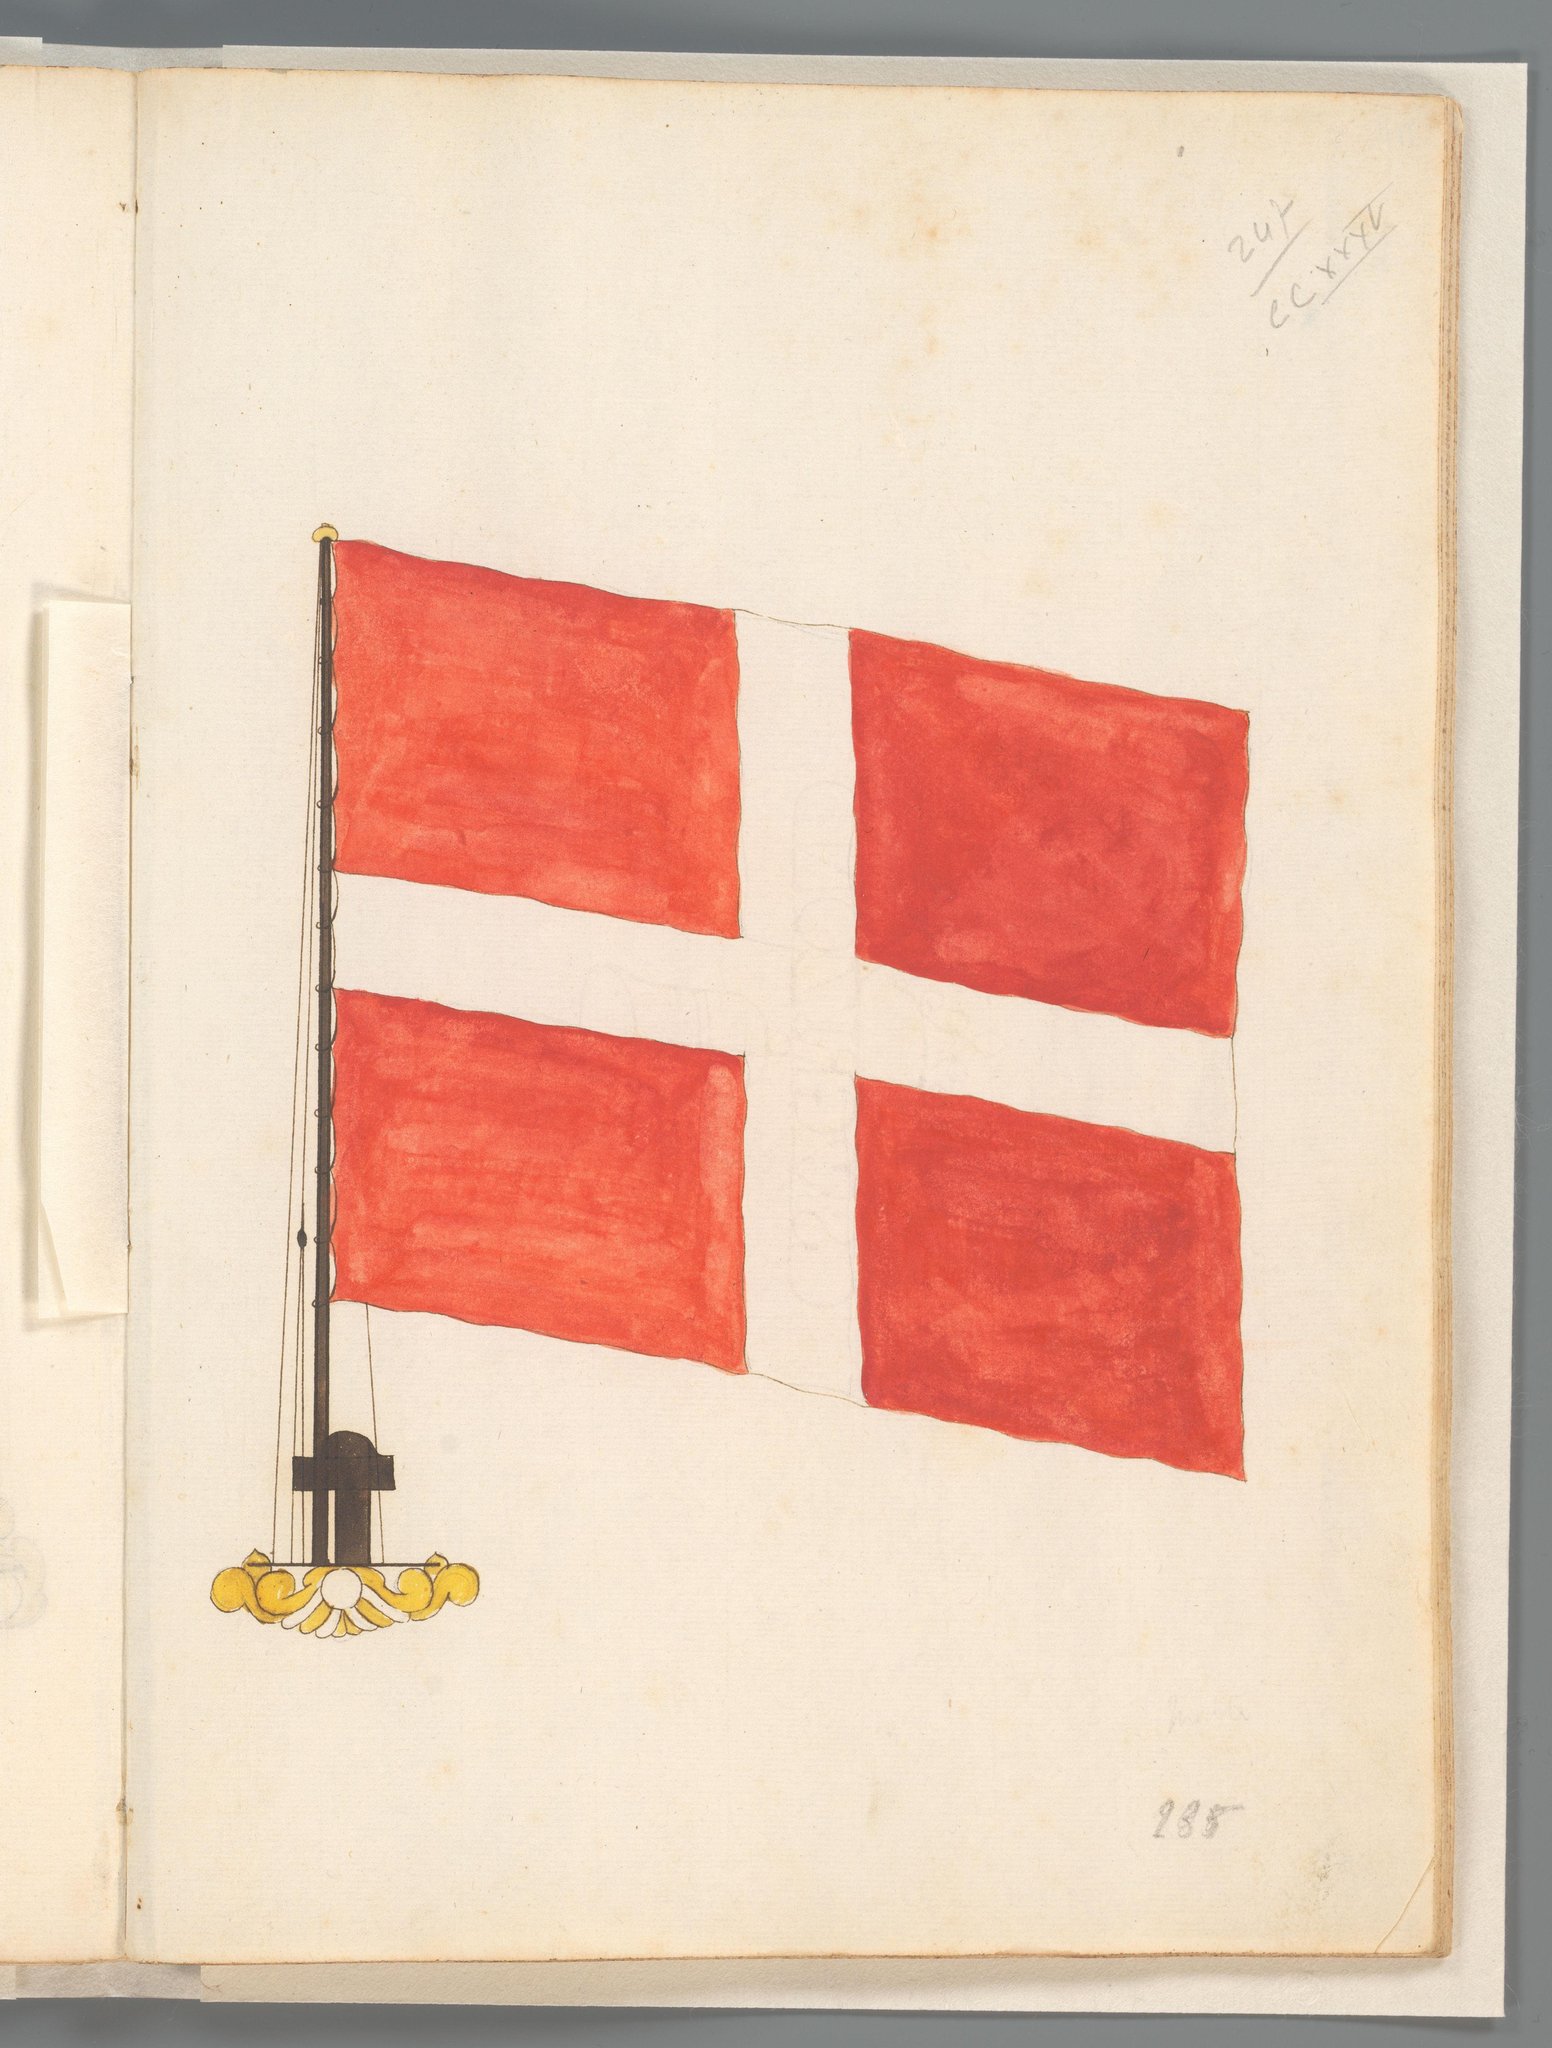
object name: drawing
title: Vlag van Malta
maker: Anonymous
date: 1667-1670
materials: ink, paper, watercolor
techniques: brush, pen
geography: france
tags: flag, colours (as symbol of the state, etc.)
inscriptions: number: ‘247 / CCXXXV / 235’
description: Vlag van Malta. Rode vlag met een witte Sint-Joriskruis. Vlag op vlaggensteng en mastvoet. Afgebeeld op folio 118r. Onderdeel van een vlaggenboek met vlaggen uit Europa, Noord-Afrika, Nabije en Verre Oosten.